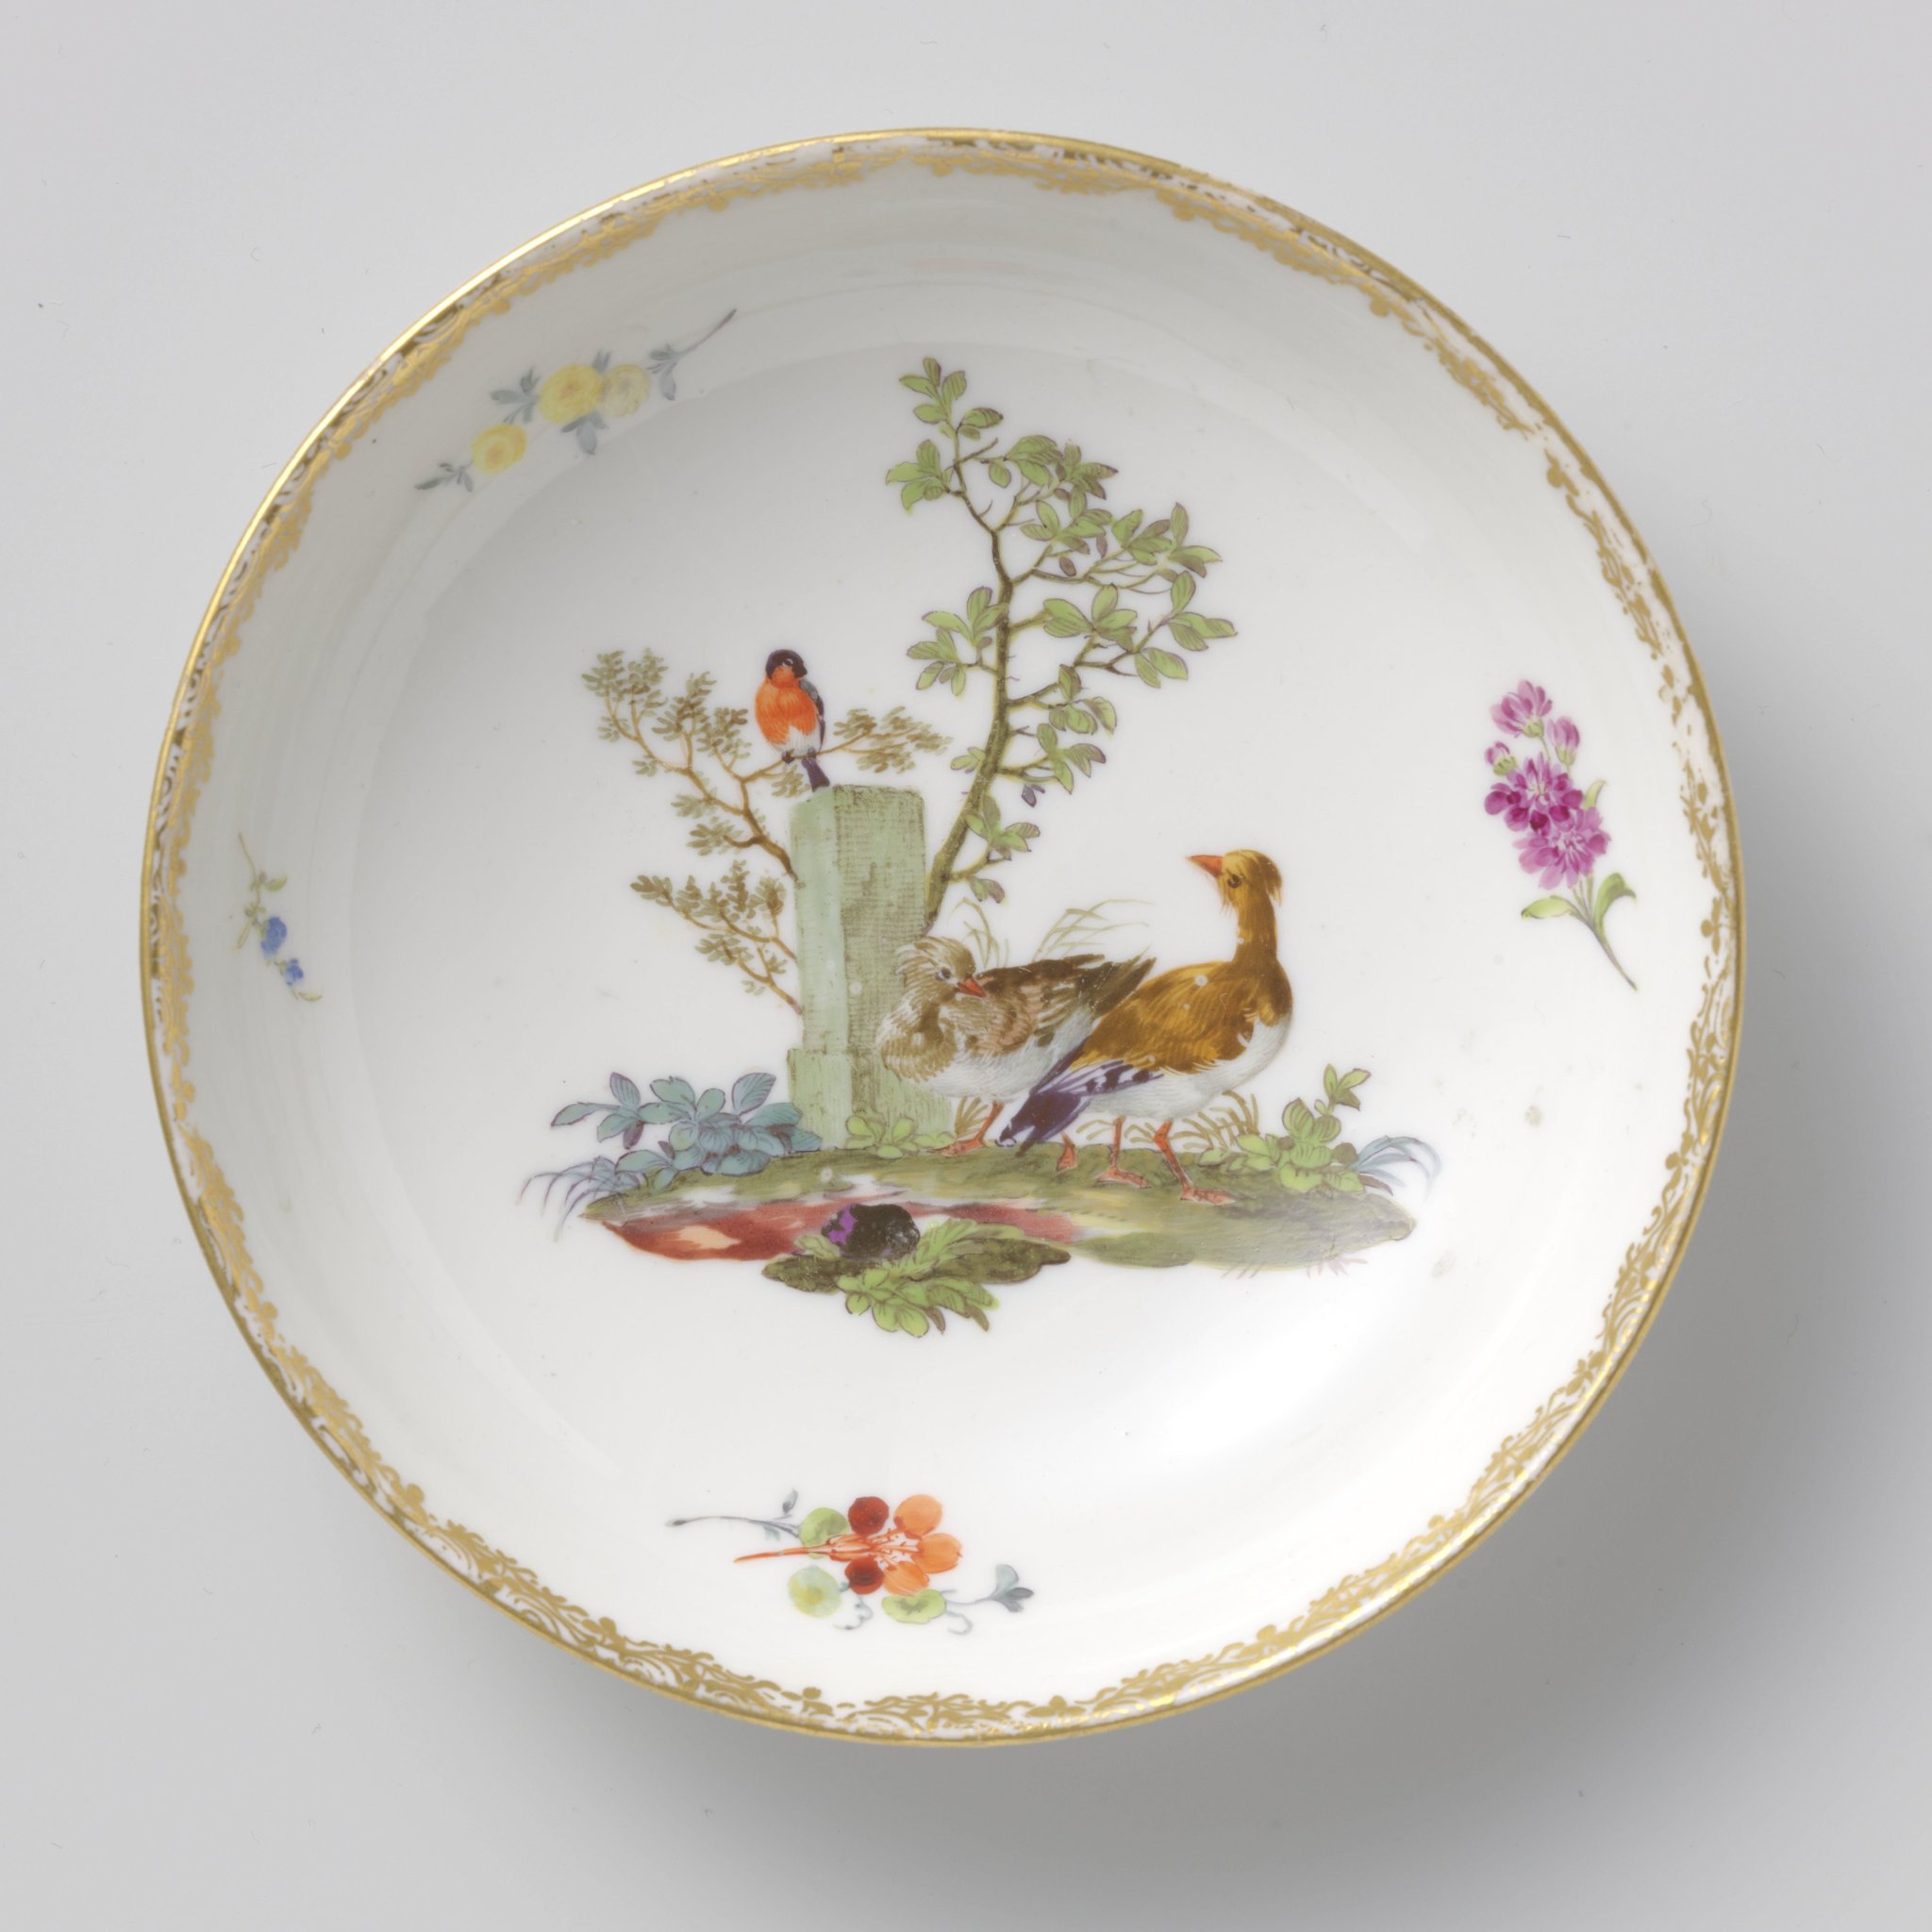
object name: eating drinking utensil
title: Schotel, veelkleurig beschilderd met vogels en bloemtakken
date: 1770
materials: porcelain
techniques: painted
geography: meissen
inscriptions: mold mark: ‘19’, mark, factory mark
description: Ronde schotel van beschilderd porselein. De schotel is beschilderd met vogels op een grond en bloemtakken. Langs de binnenrand loopt een ornamentrand in goud. De schotel is gemerkt.